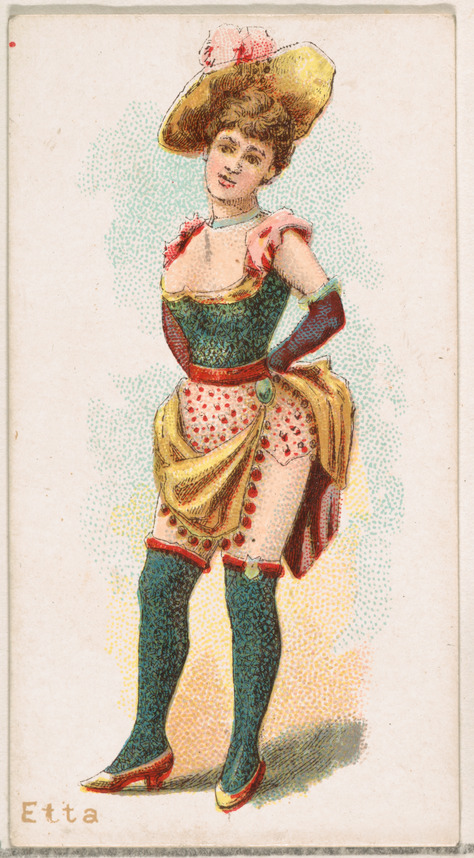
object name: print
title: Etta, from the Ballet Queens series (N182) issued by Wm. S. Kimball & Co.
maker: william s. kimball & company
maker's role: publisher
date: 1889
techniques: color lithograph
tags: women,dancers